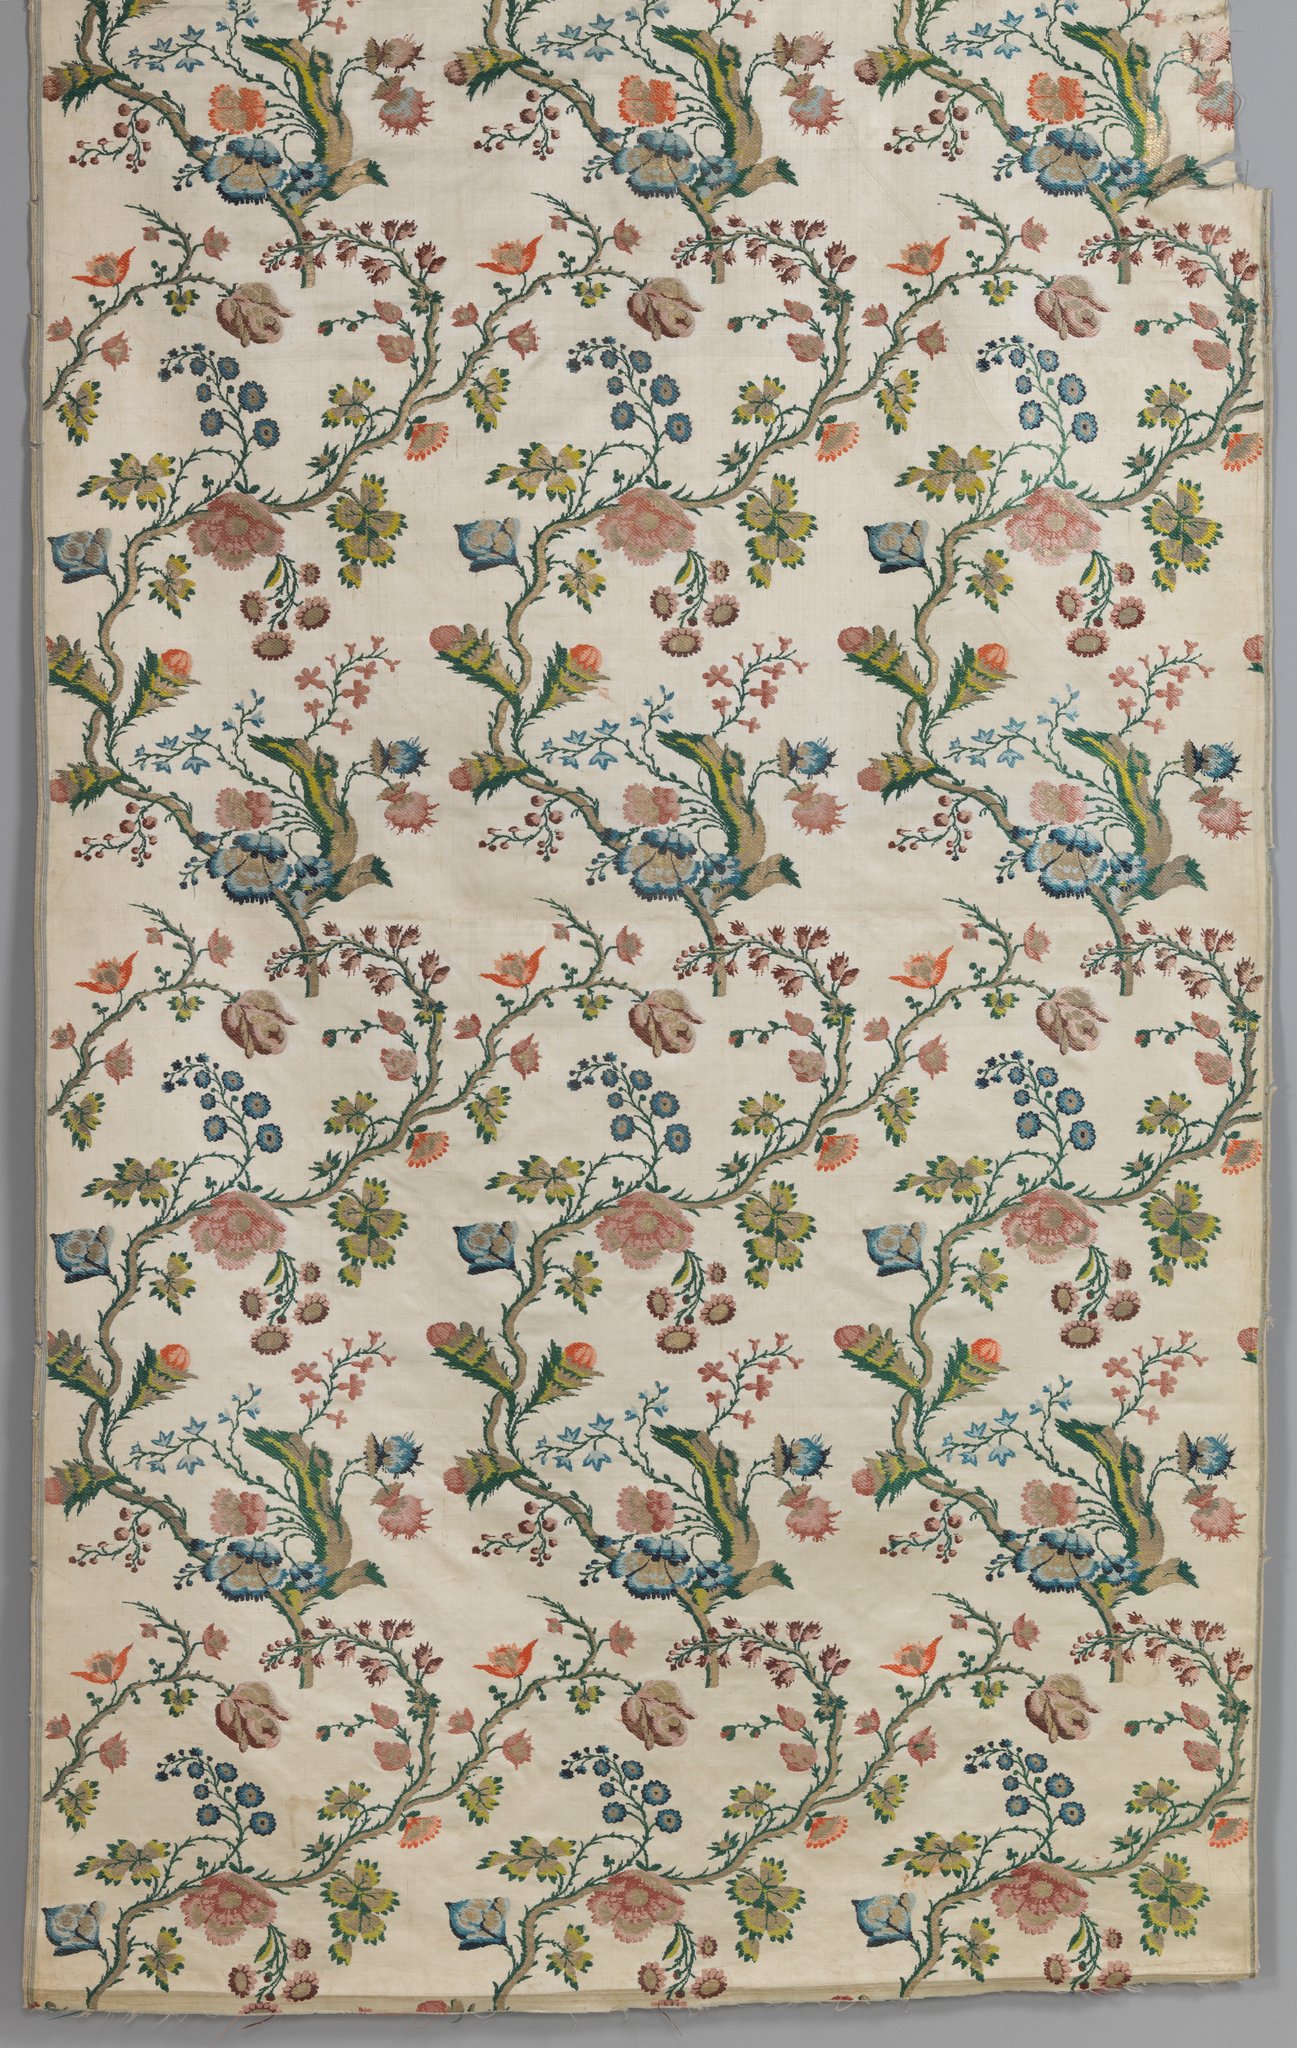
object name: piece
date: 1734-1766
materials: metal thread, silk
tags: flowers